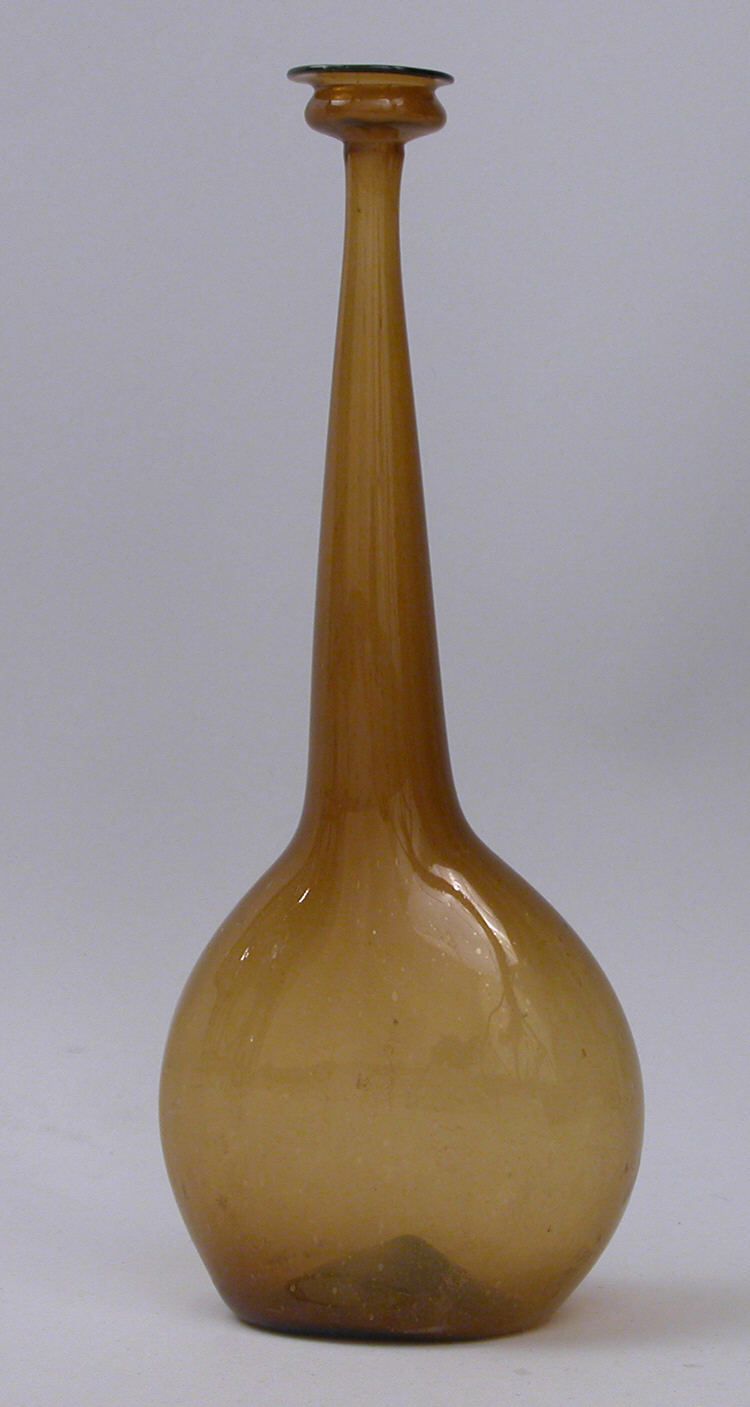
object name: bottle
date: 1701-1900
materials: glass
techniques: glassblowing, tooling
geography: iran